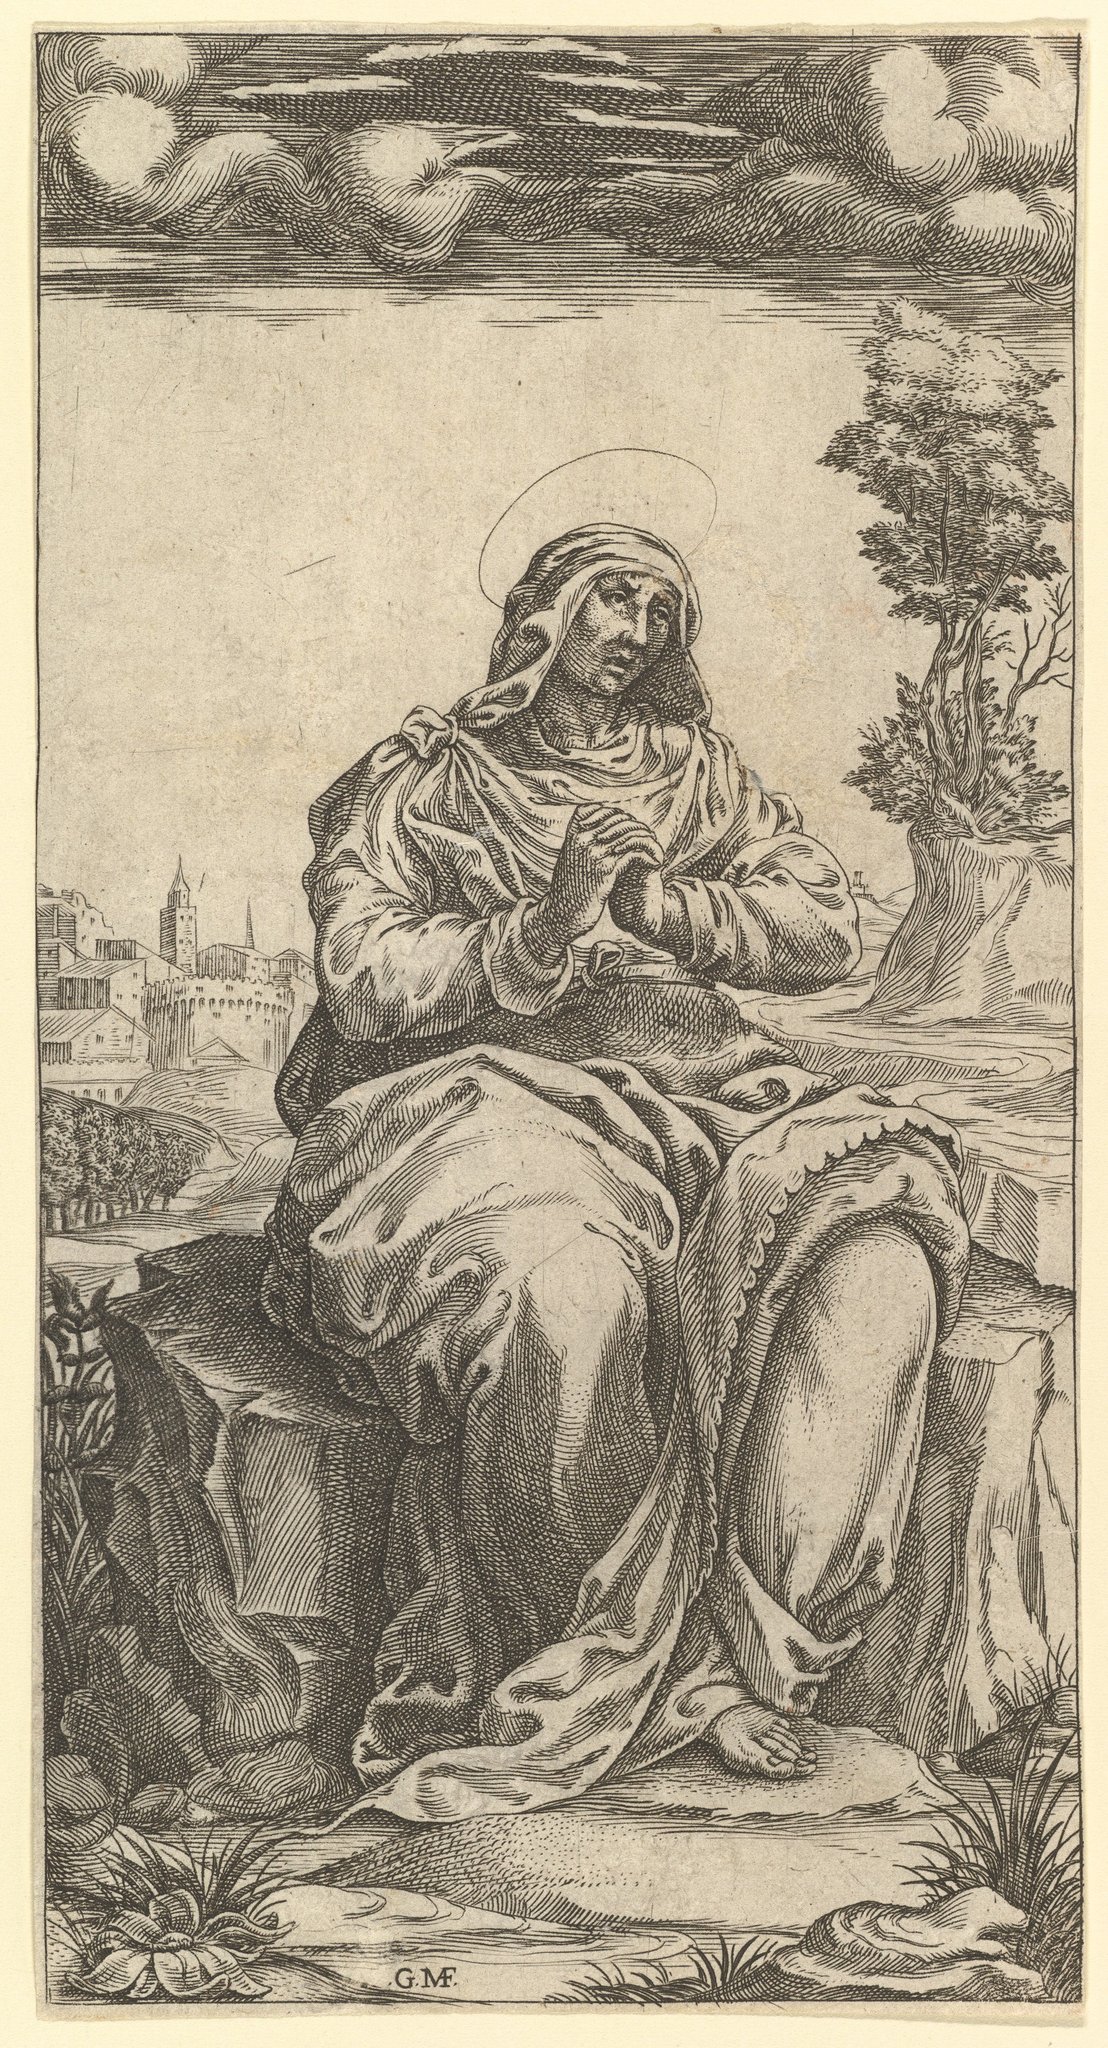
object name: print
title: The Virgin of Sorrows; central part of a print with nine surounding compartments, now separated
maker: giorgio ghisi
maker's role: artist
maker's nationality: italian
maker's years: 1515-1582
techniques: engraving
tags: sadness,virgin mary